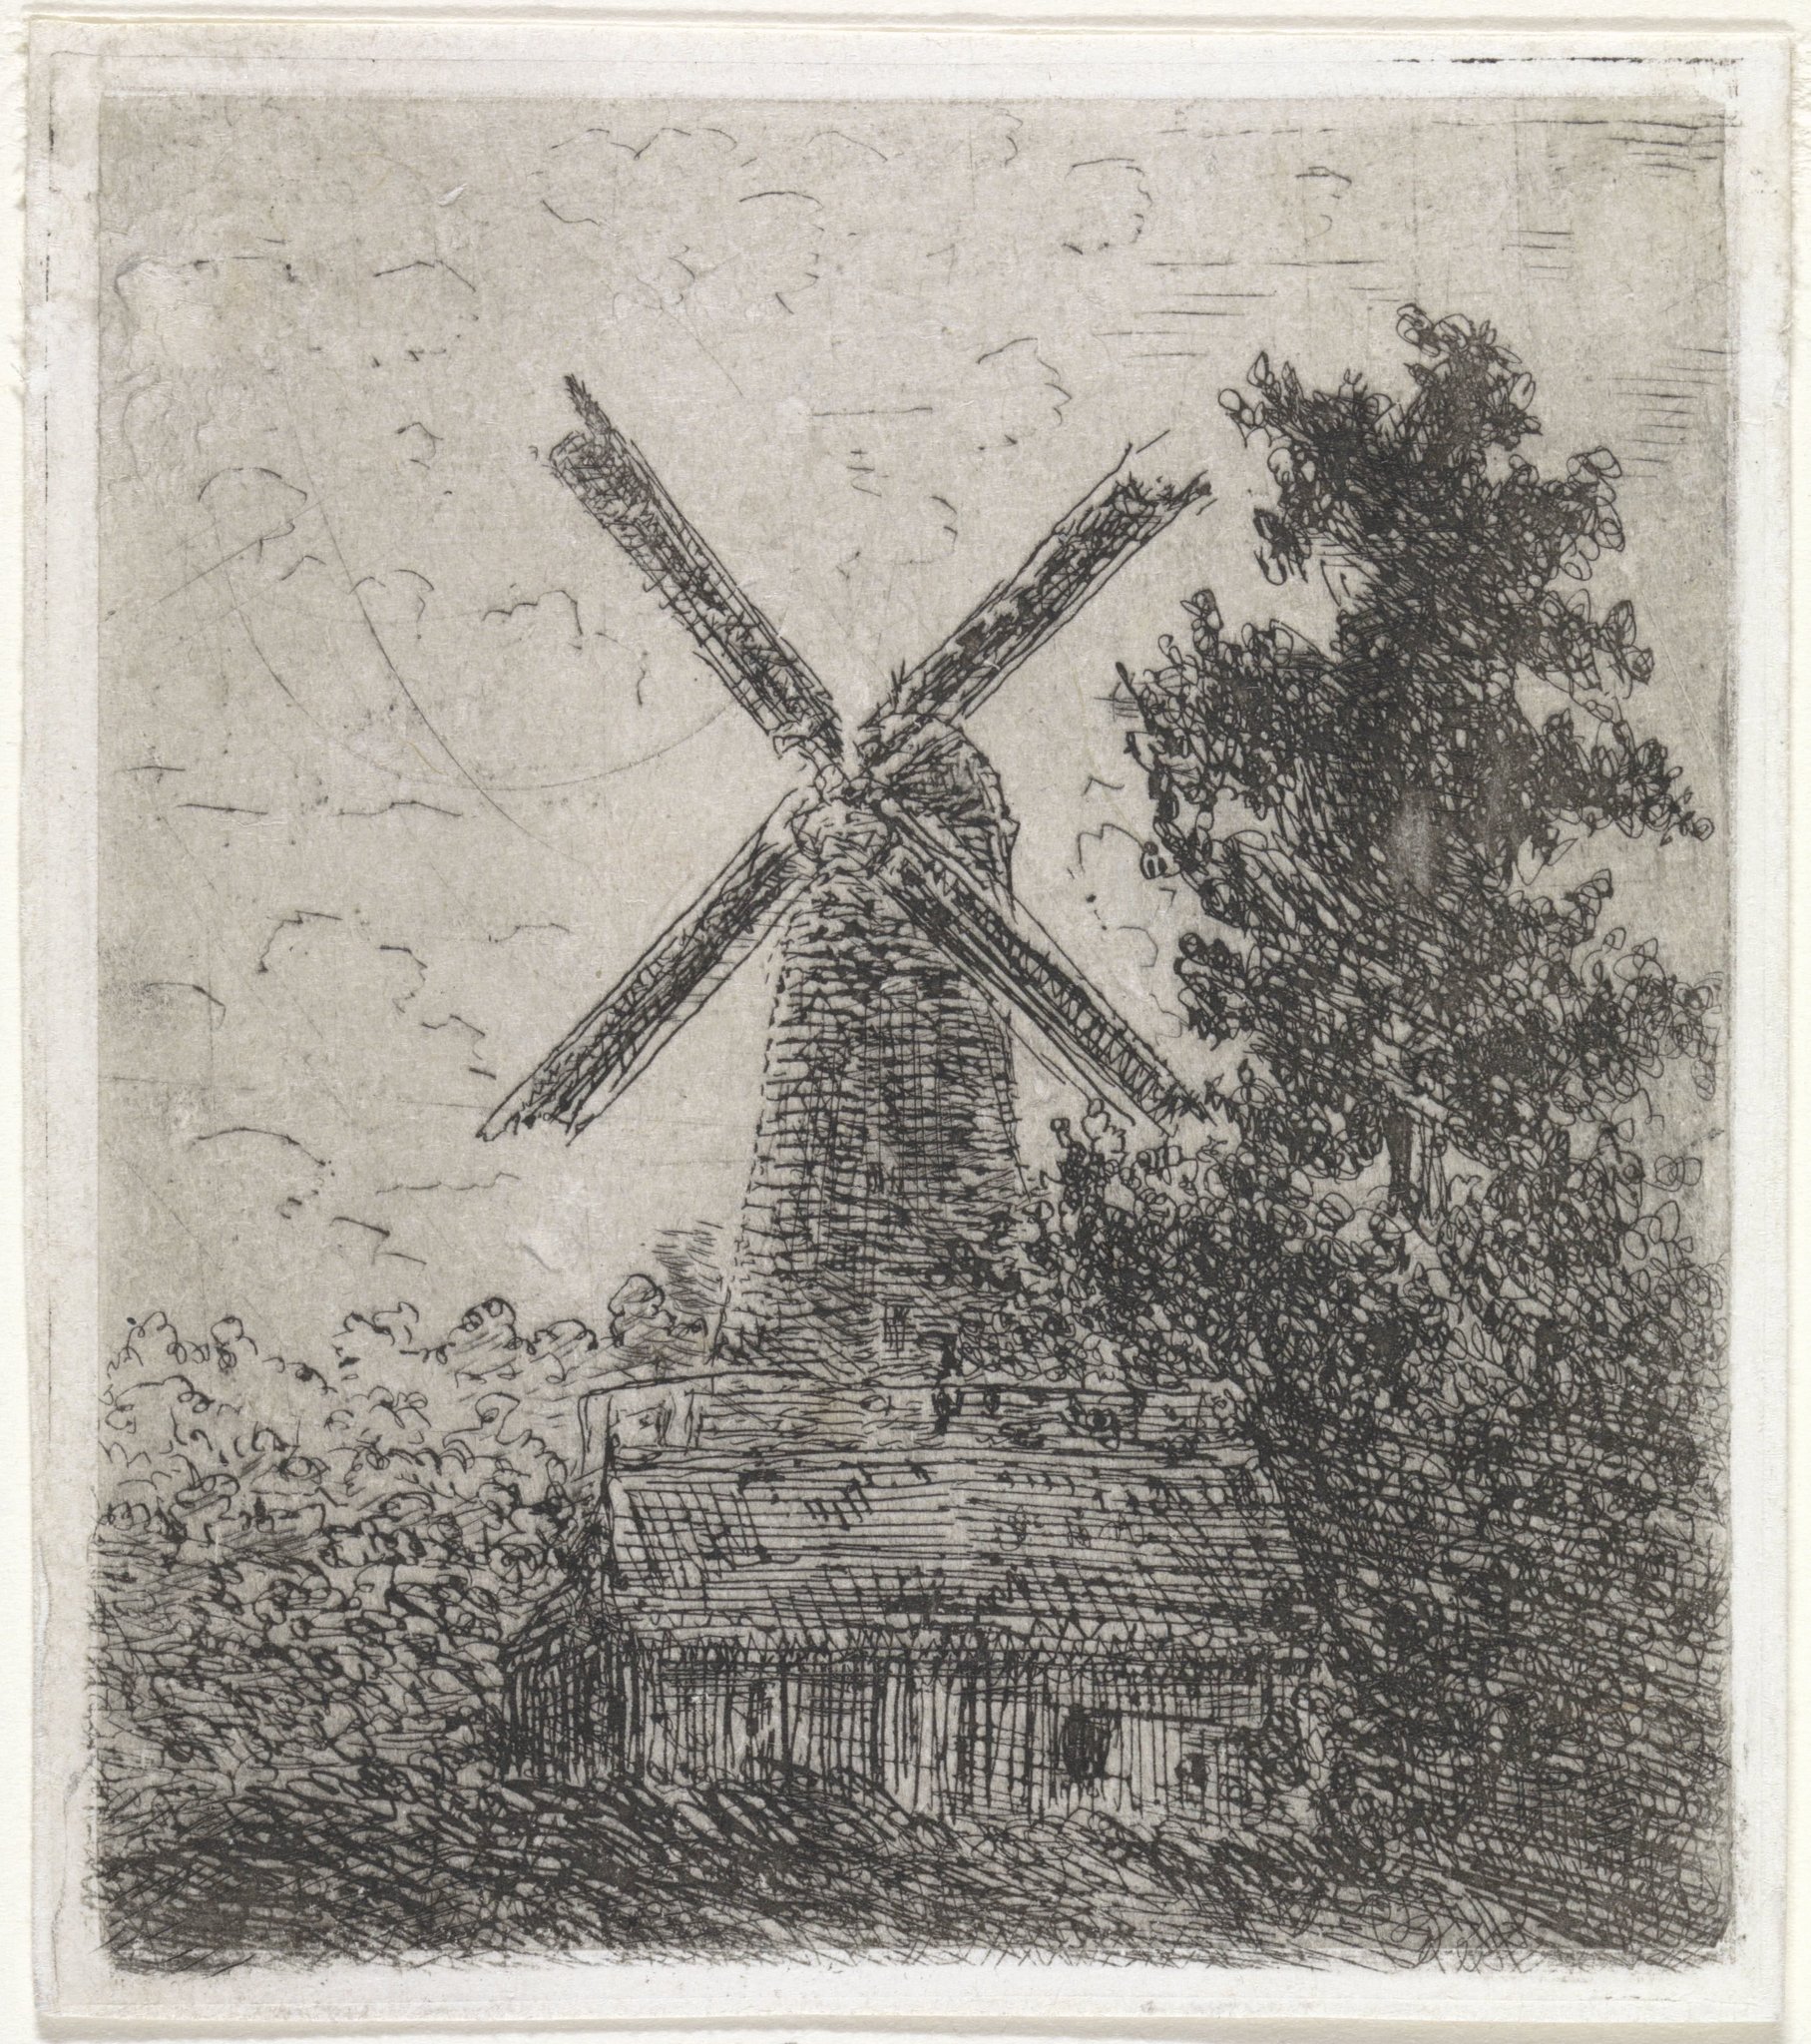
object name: print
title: Windmolen achter een hut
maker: arnoud schaepkens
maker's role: print maker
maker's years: 1816-1904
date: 1855-1904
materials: paper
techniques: drypoint, etching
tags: windmill in landscape, cottage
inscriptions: collector's mark: Lugt 2228